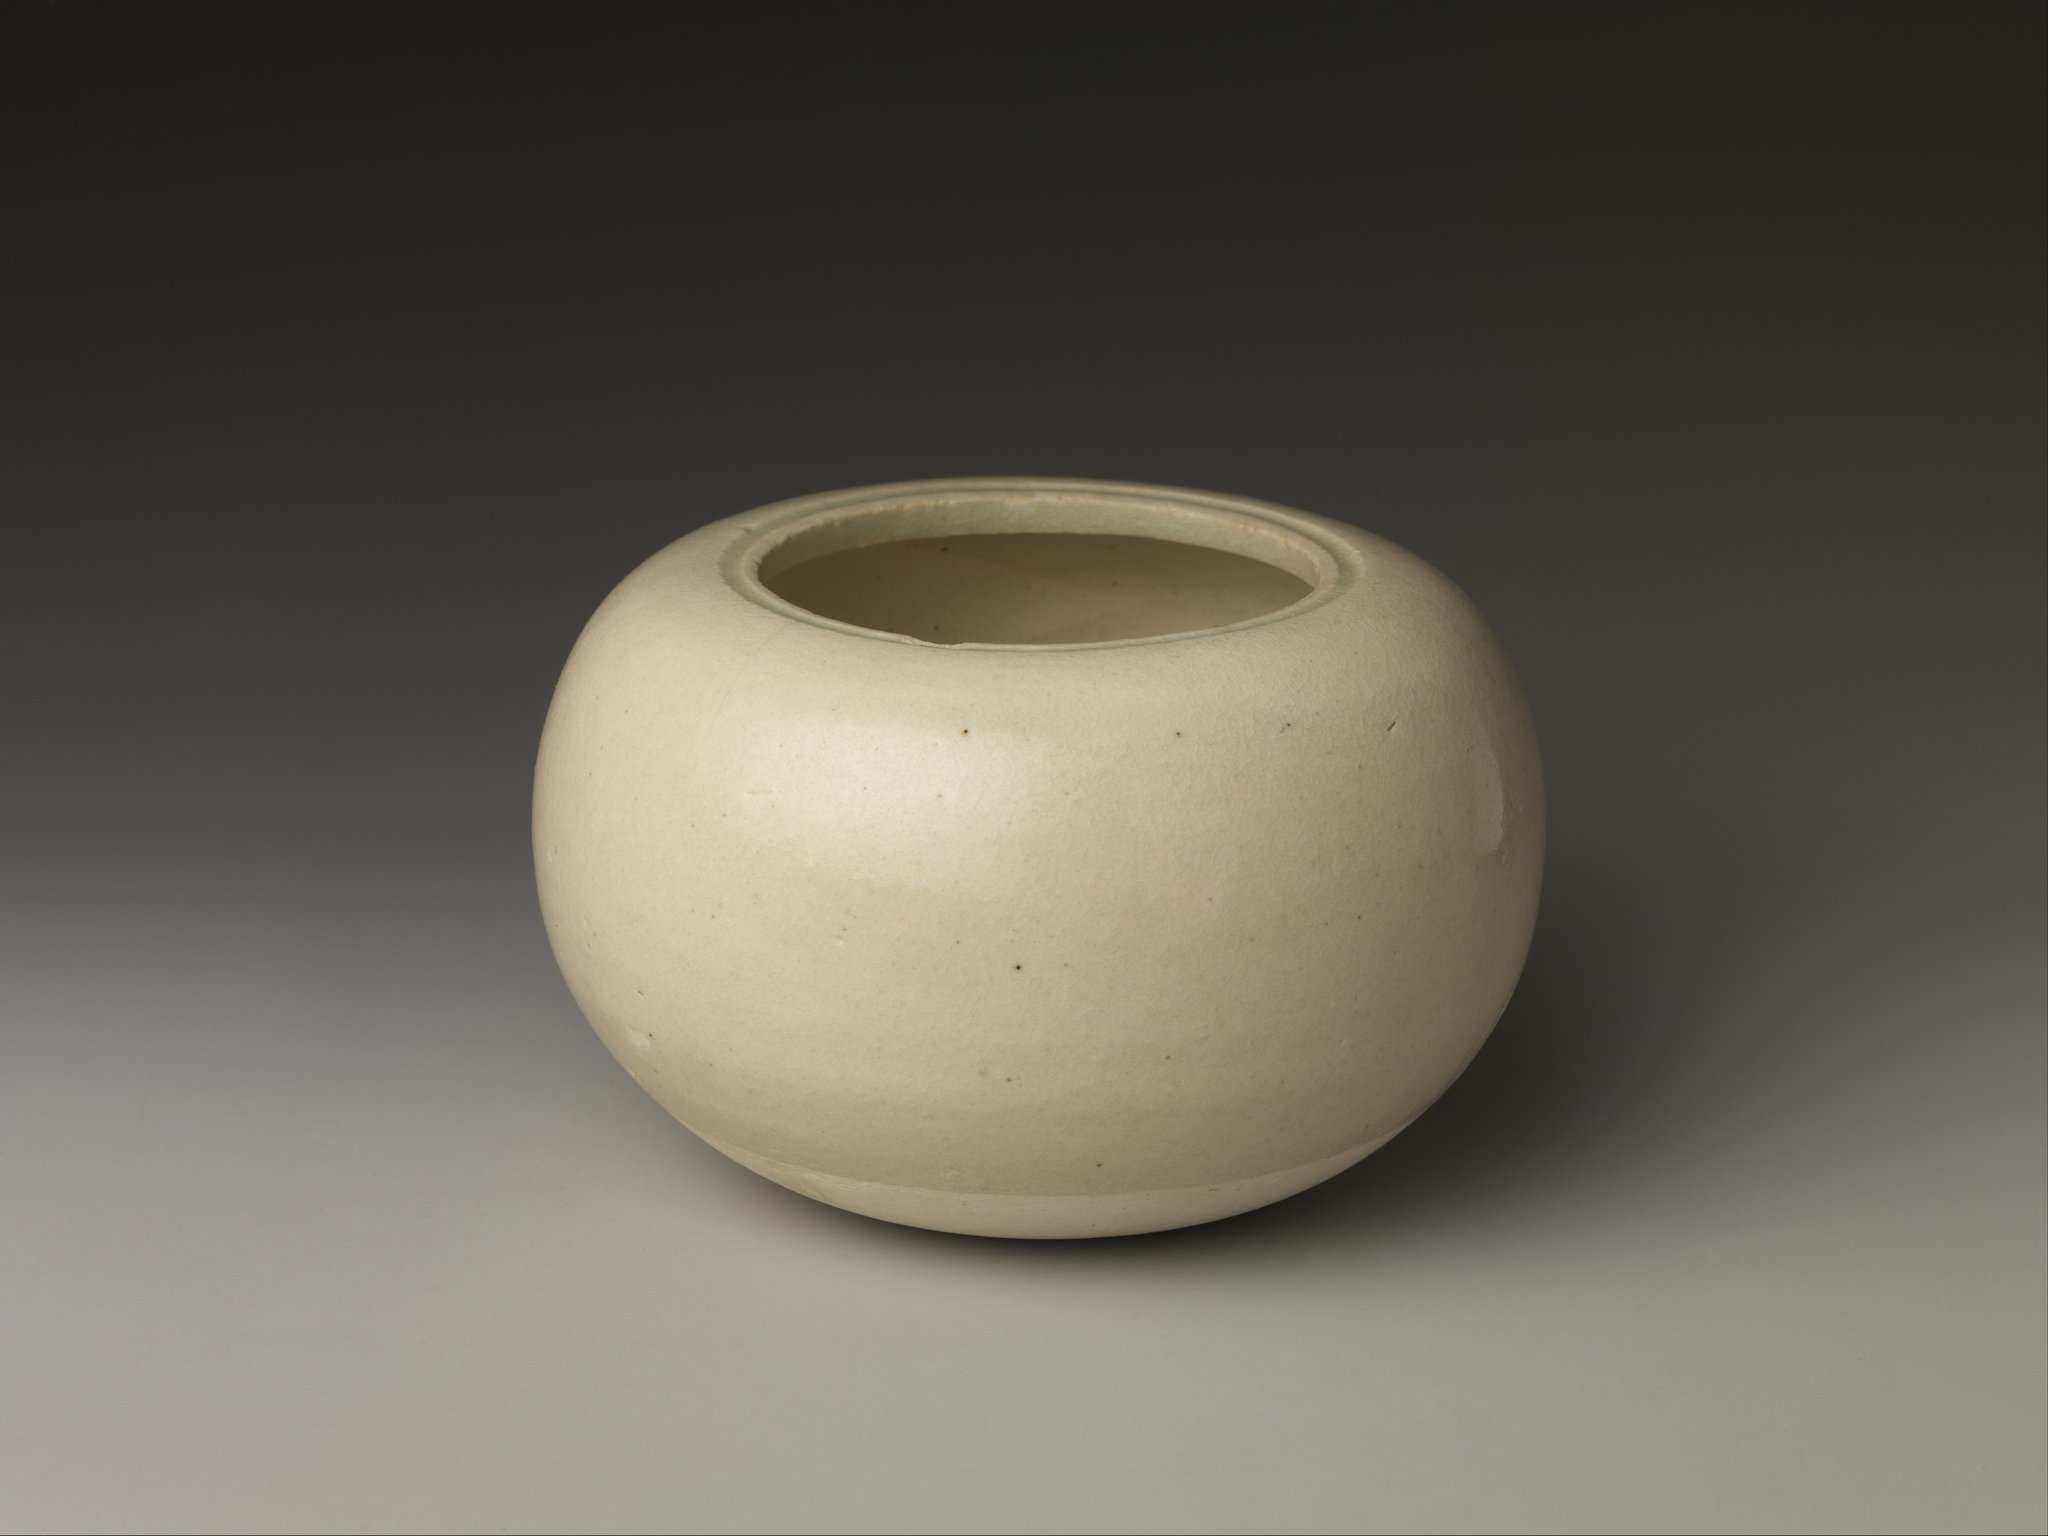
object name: bowl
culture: chinese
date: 601-700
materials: glaze, porcelain